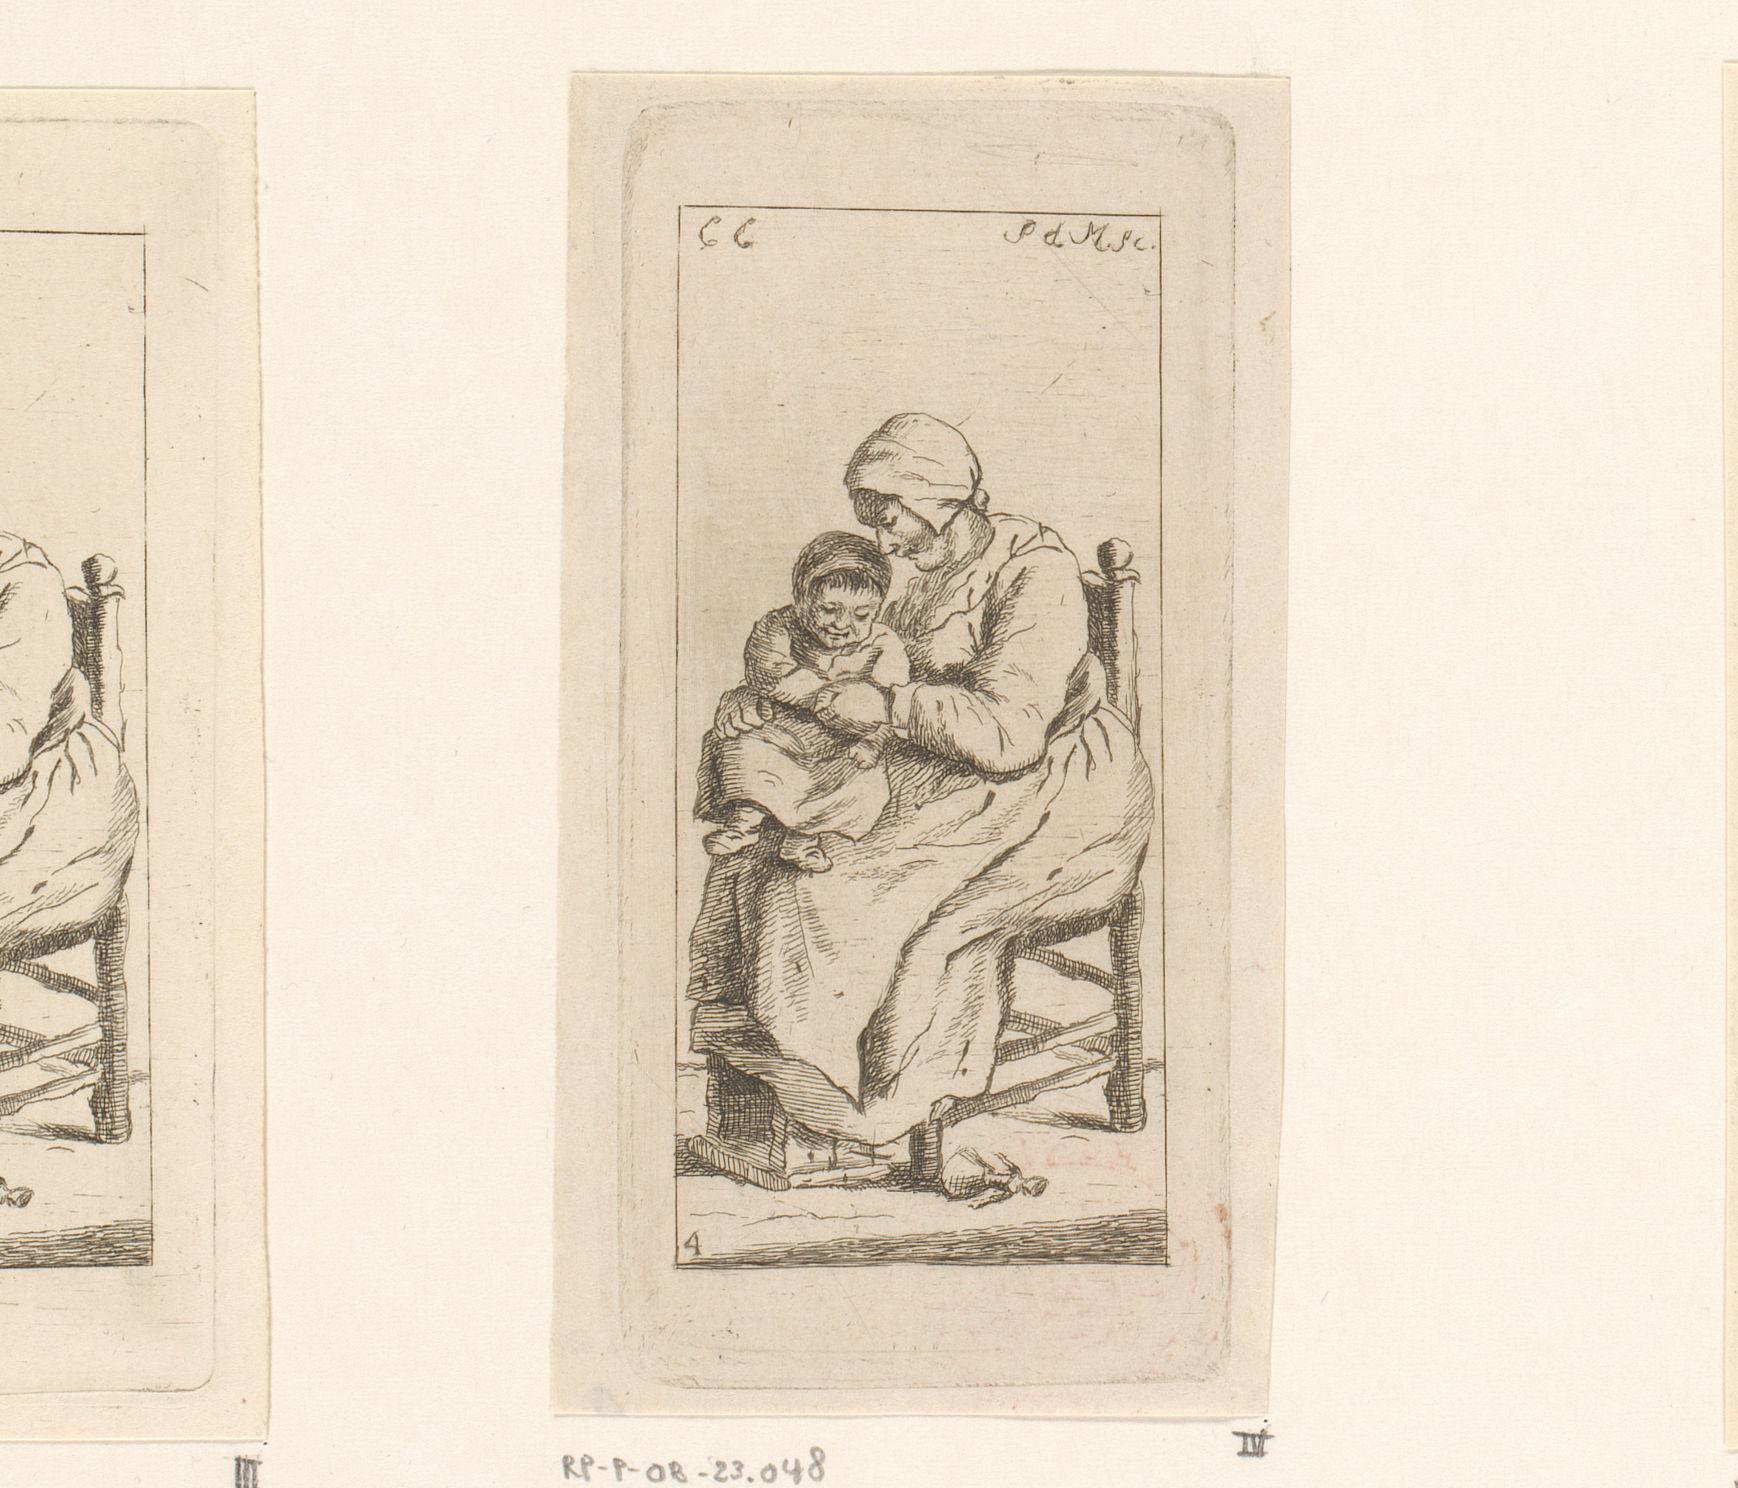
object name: print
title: Zittende moeder met kind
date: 1779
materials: paper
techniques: etching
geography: leiden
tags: mother and baby or young child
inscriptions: collector's mark: Lugt 240